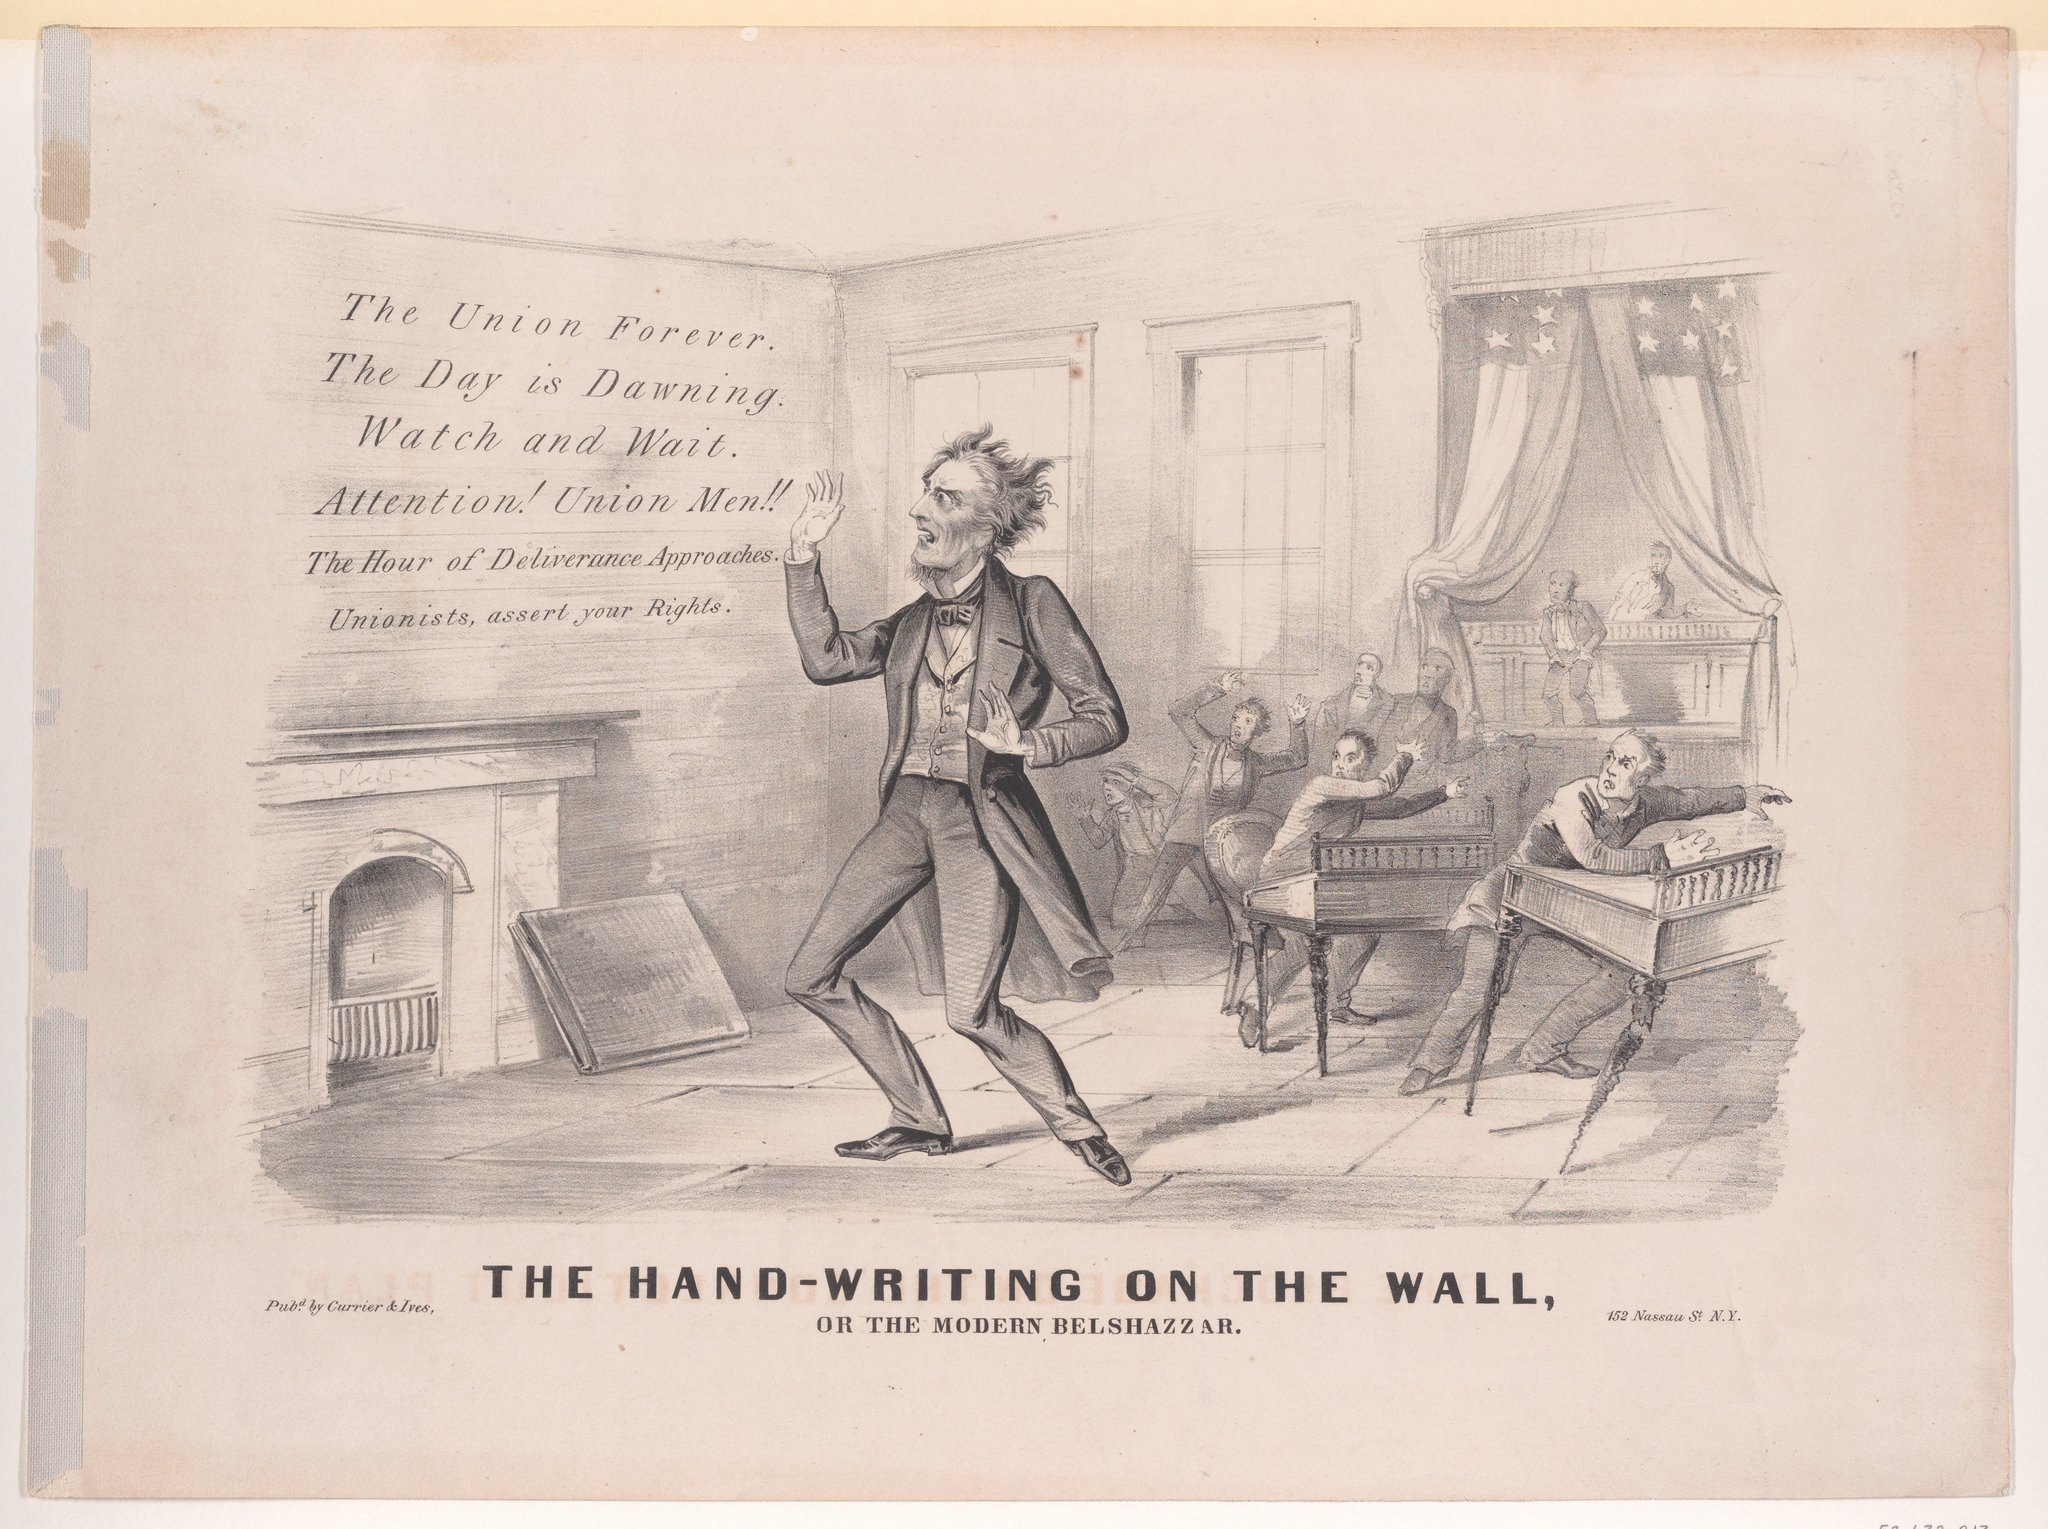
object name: print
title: The Hand-Writing On the Wall, Or the Modern Belshazzar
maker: currier & ives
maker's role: publisher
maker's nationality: american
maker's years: 1857-1907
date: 1865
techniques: lithograph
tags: satire,american civil war,men